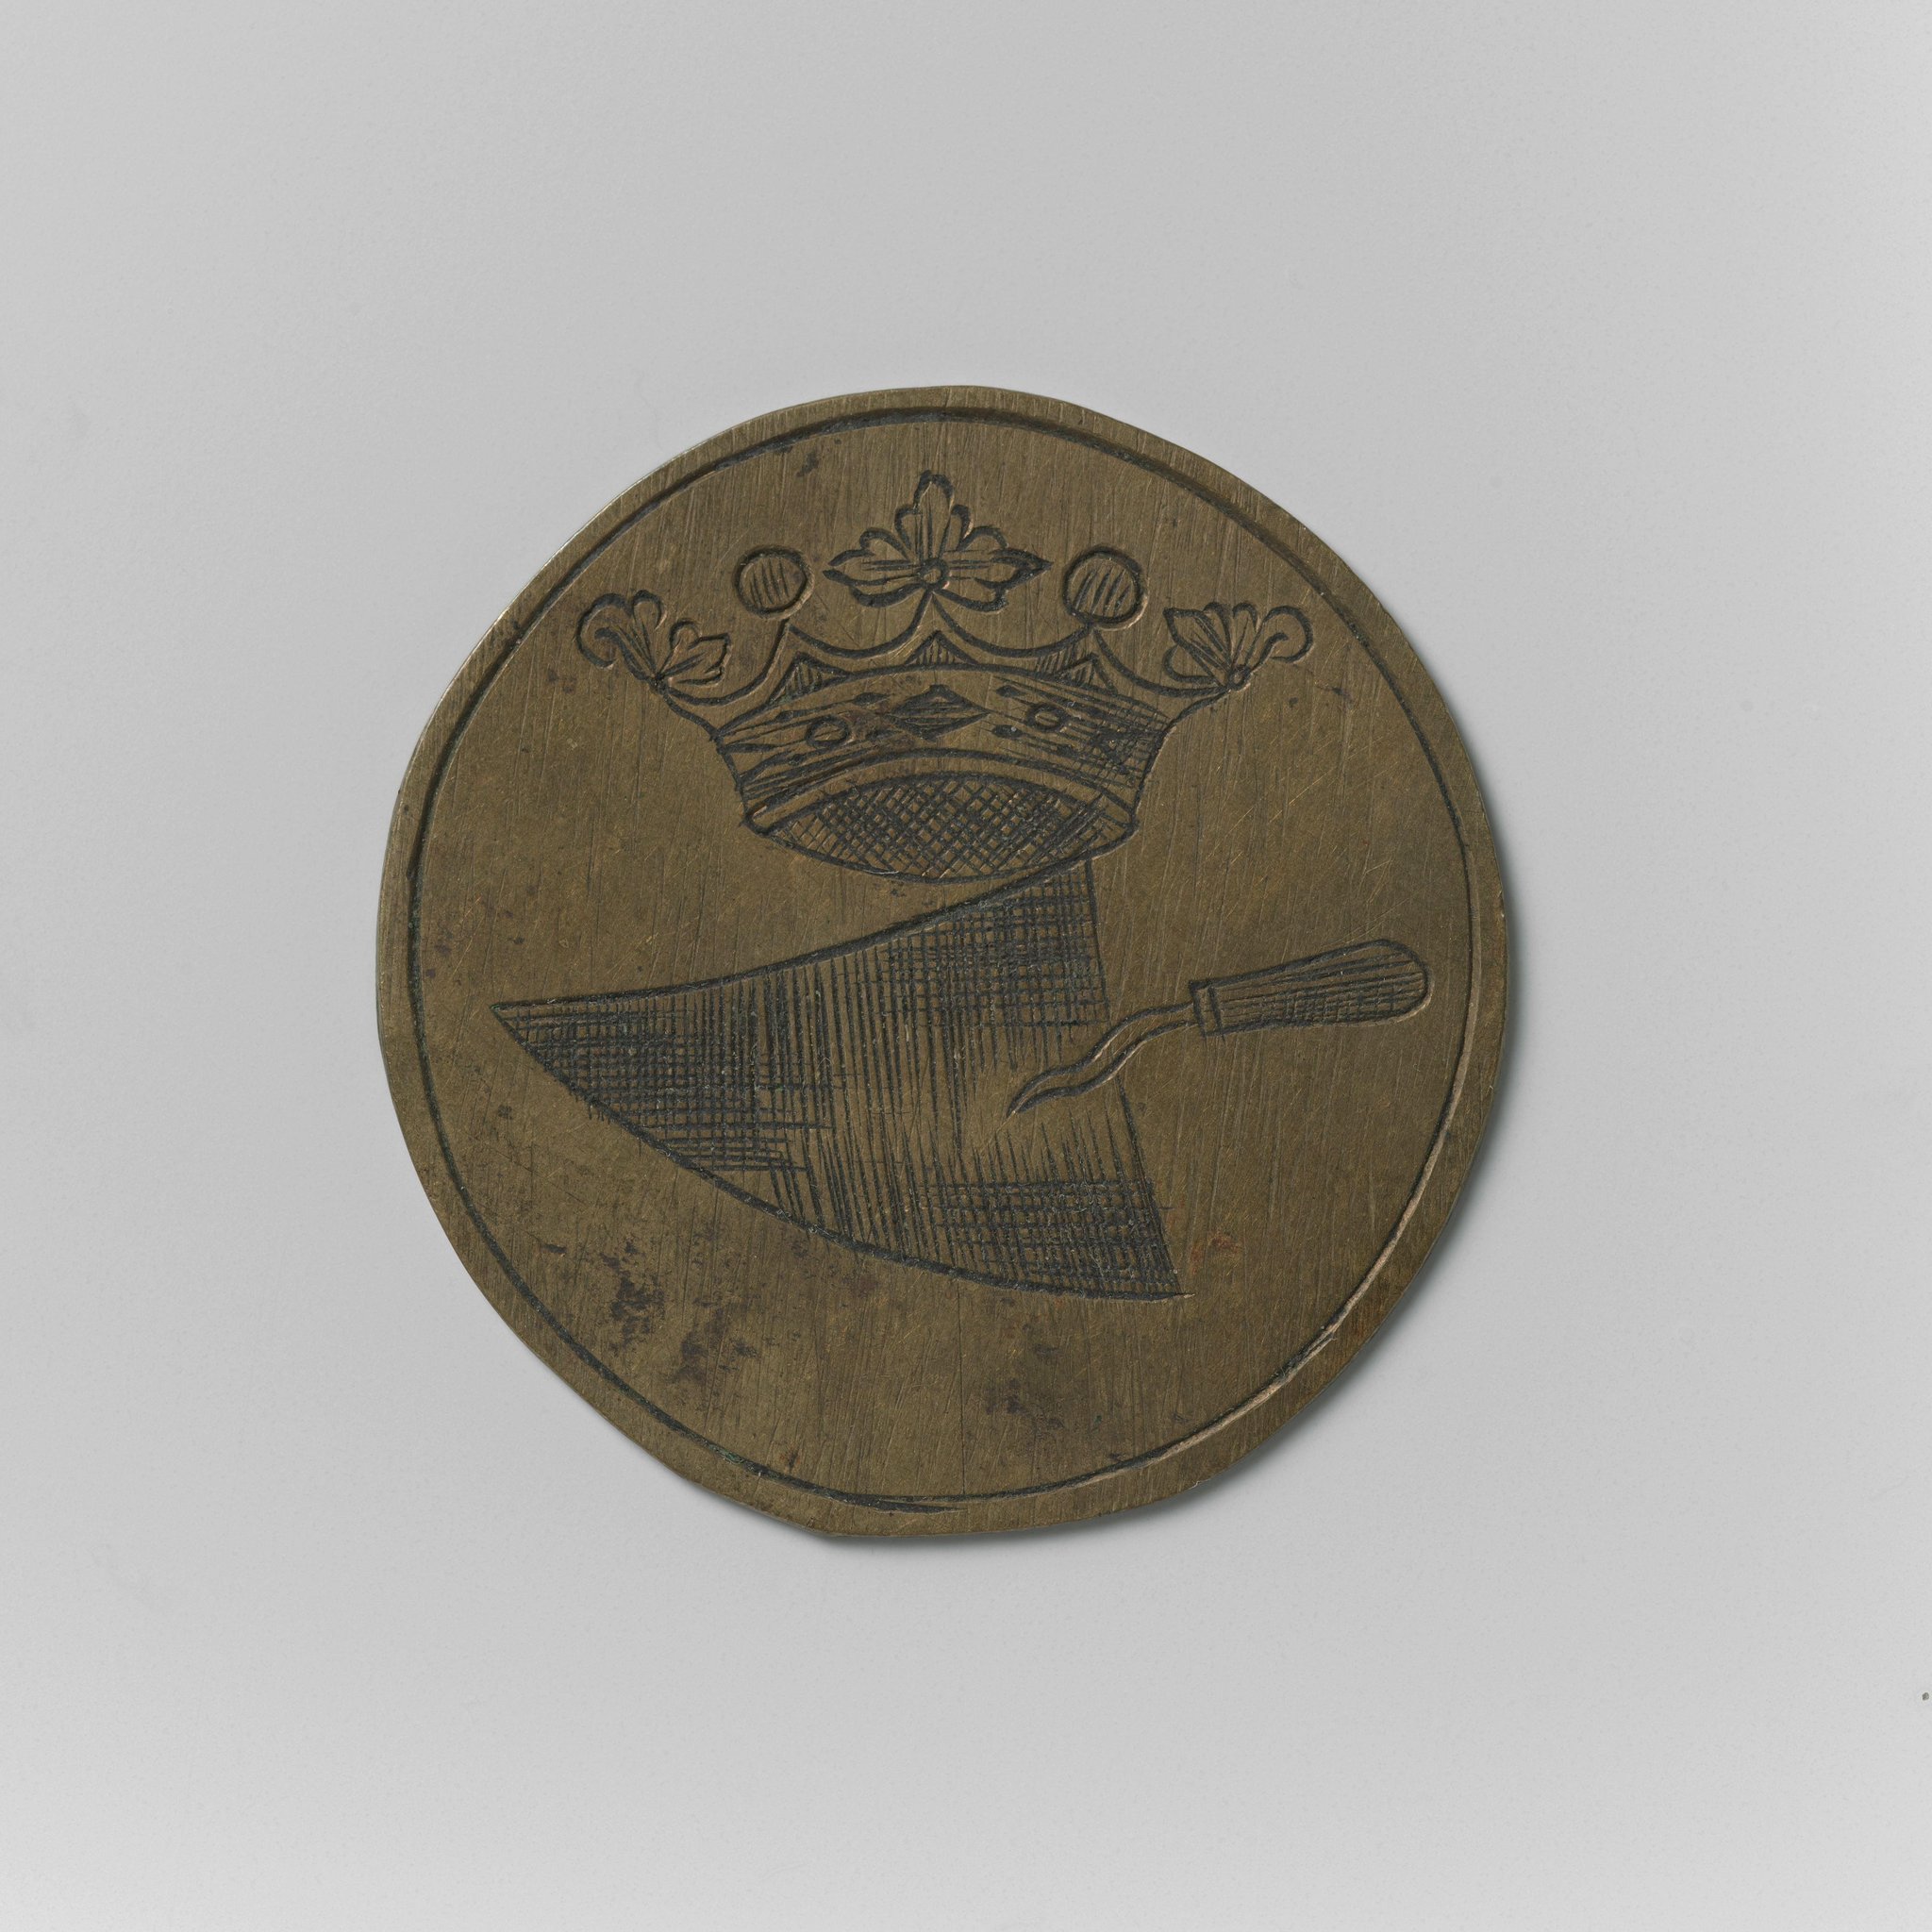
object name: history medal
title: Presentiepenning van het Metselaarsgilde te Amsterdam, 1730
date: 1730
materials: brass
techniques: engraving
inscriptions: inscription: ‘A° 1765 / Den 4 Maart / Albert / Knoppers / MrM.’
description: Ronde plaat messing gegraveerd op de voorzijde een gekroonde liggende troffel, op de keerzijde vijf regels tekst, op naam van Albert Knoppers 1765